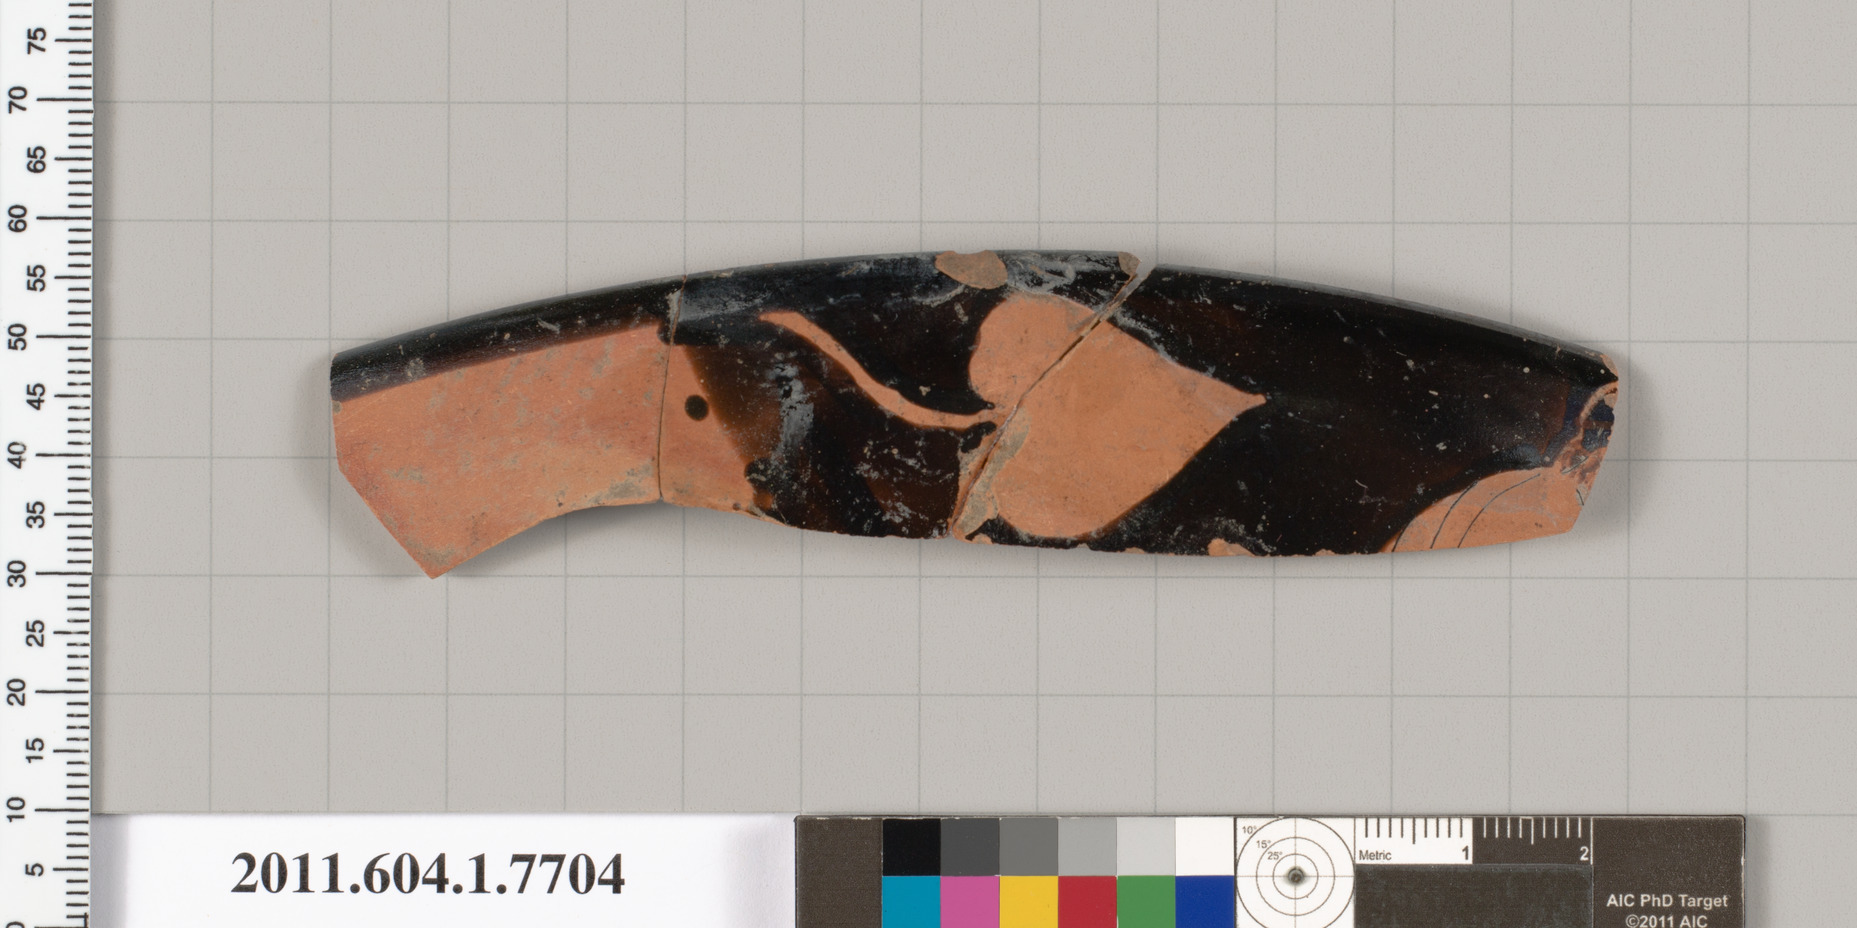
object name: kylix fragment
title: Terracotta fragment of a kylix (drinking cup)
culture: greek, attic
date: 460-450 BCE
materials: terracotta